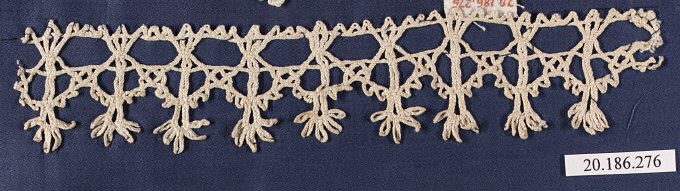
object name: edging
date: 1501-1600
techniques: lace